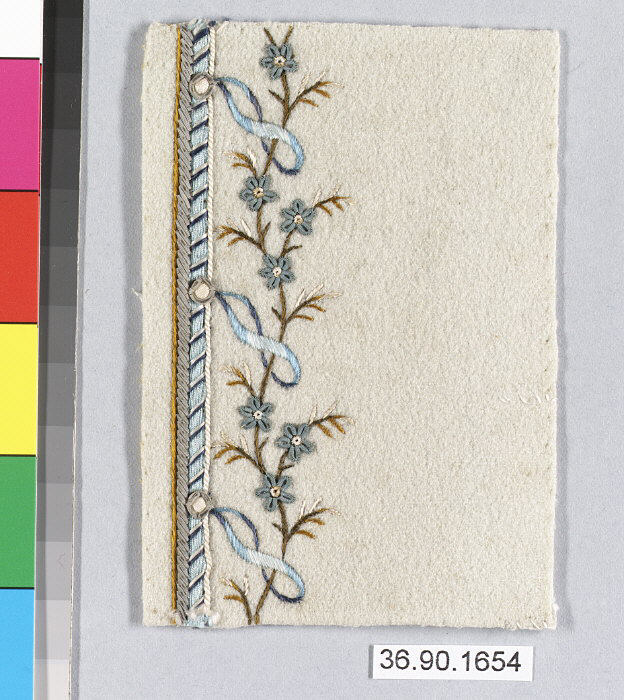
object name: sample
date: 1801-1833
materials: felt, metal thread, silk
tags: flowers